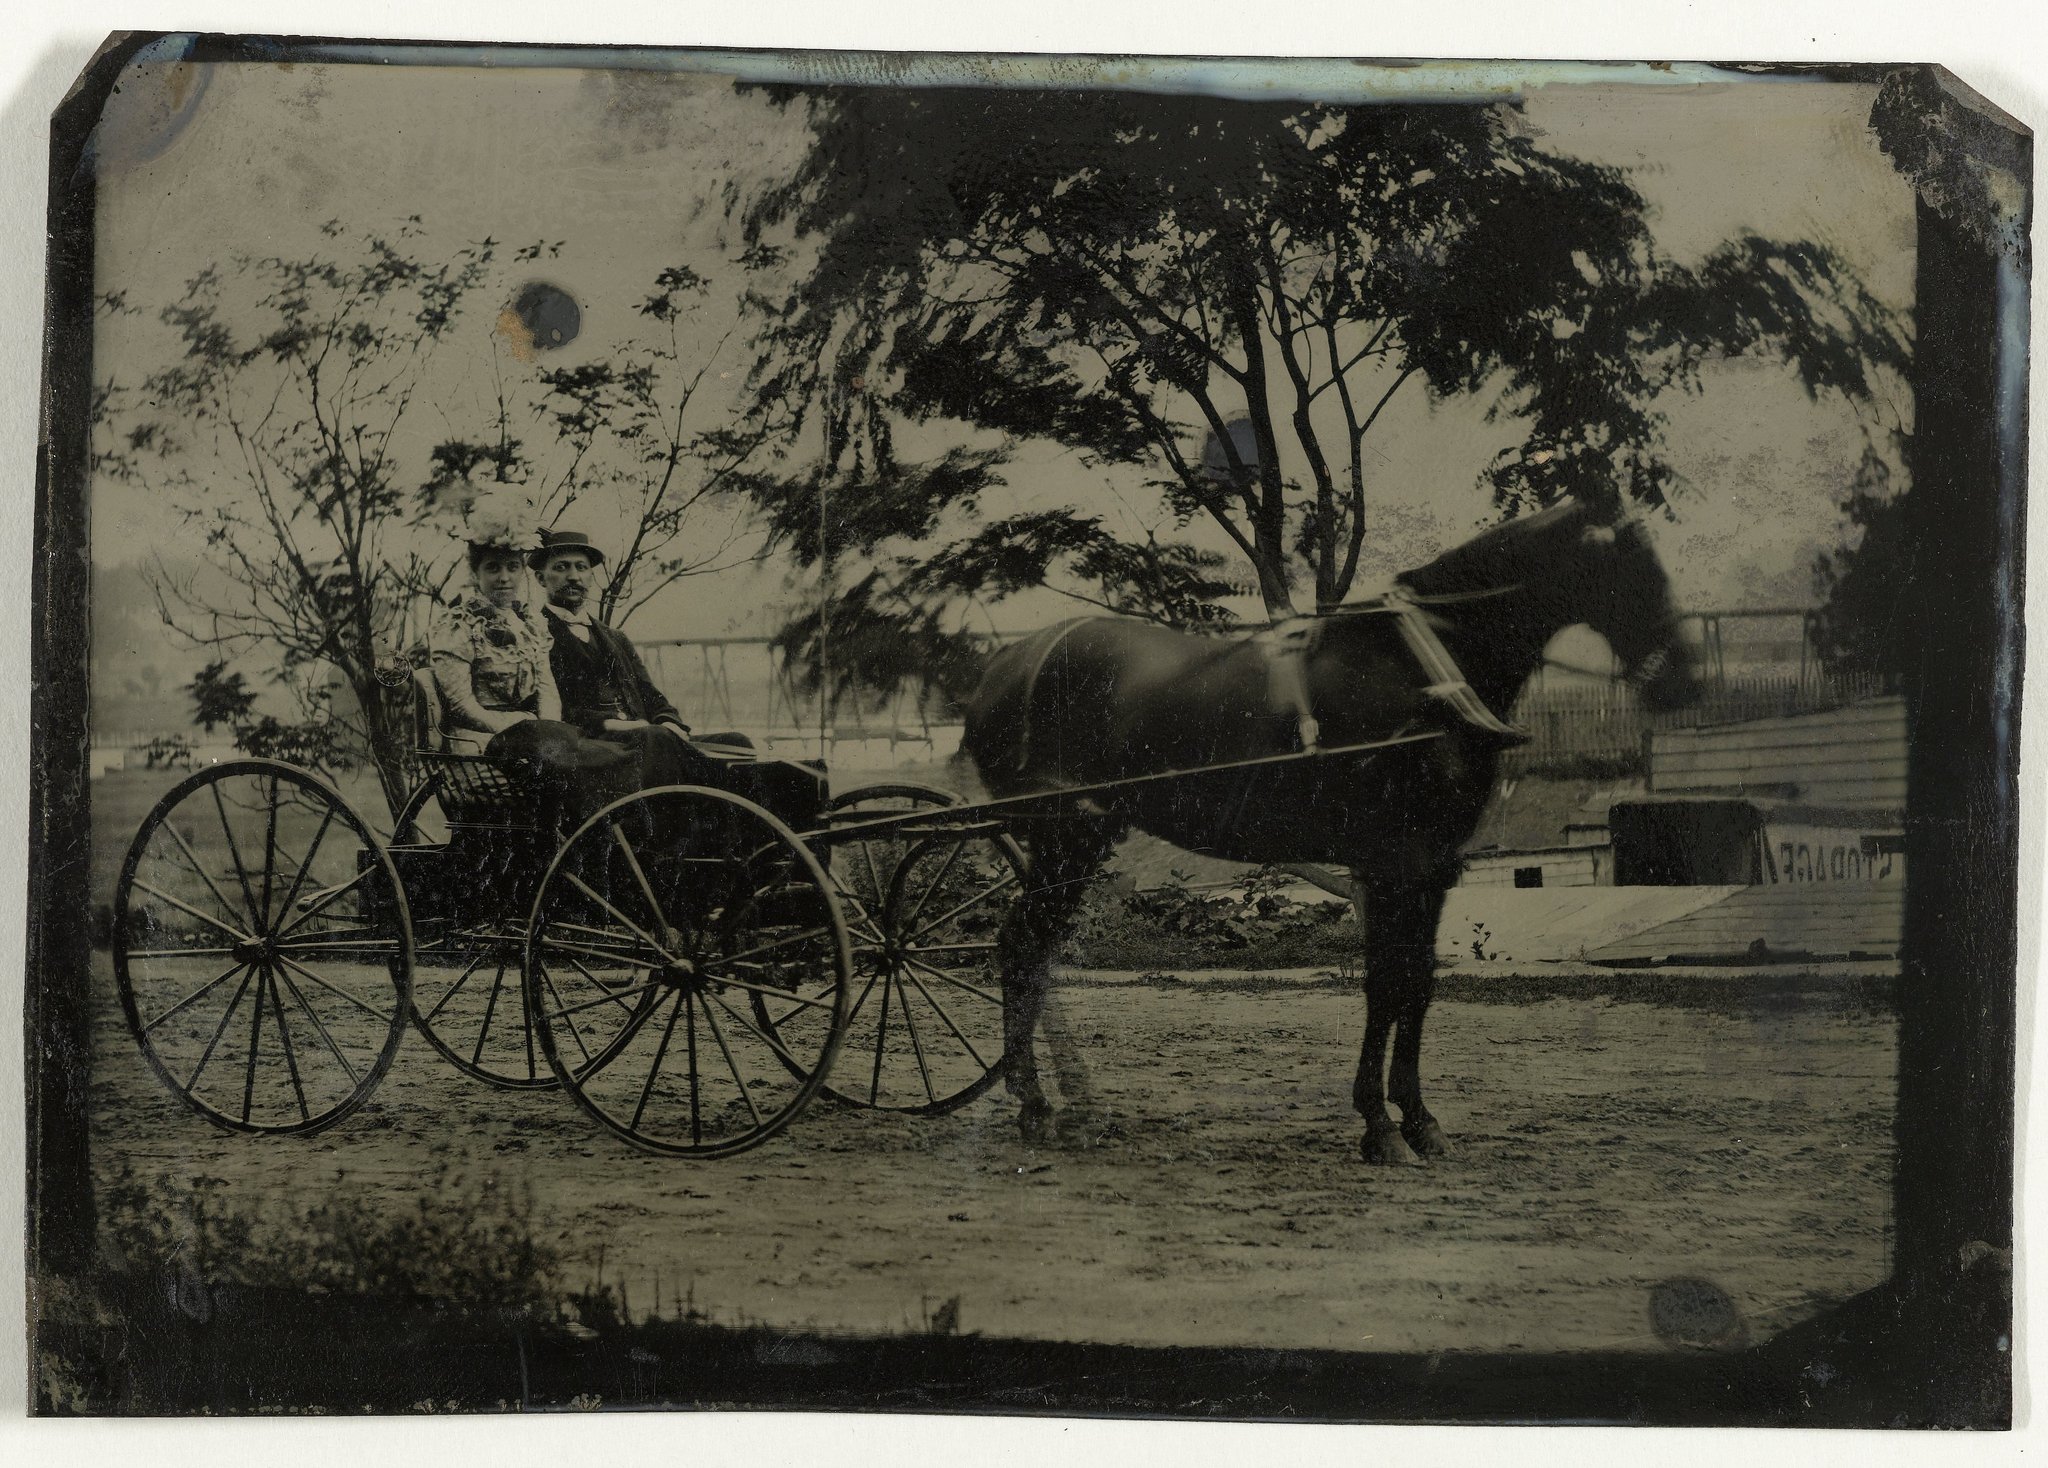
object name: photograph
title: Man en vrouw in een koets met een paard er voor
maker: Anonymous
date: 1860-1900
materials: metal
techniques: ferrotyping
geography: united states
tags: four-wheeled vehicle drawn by one animal